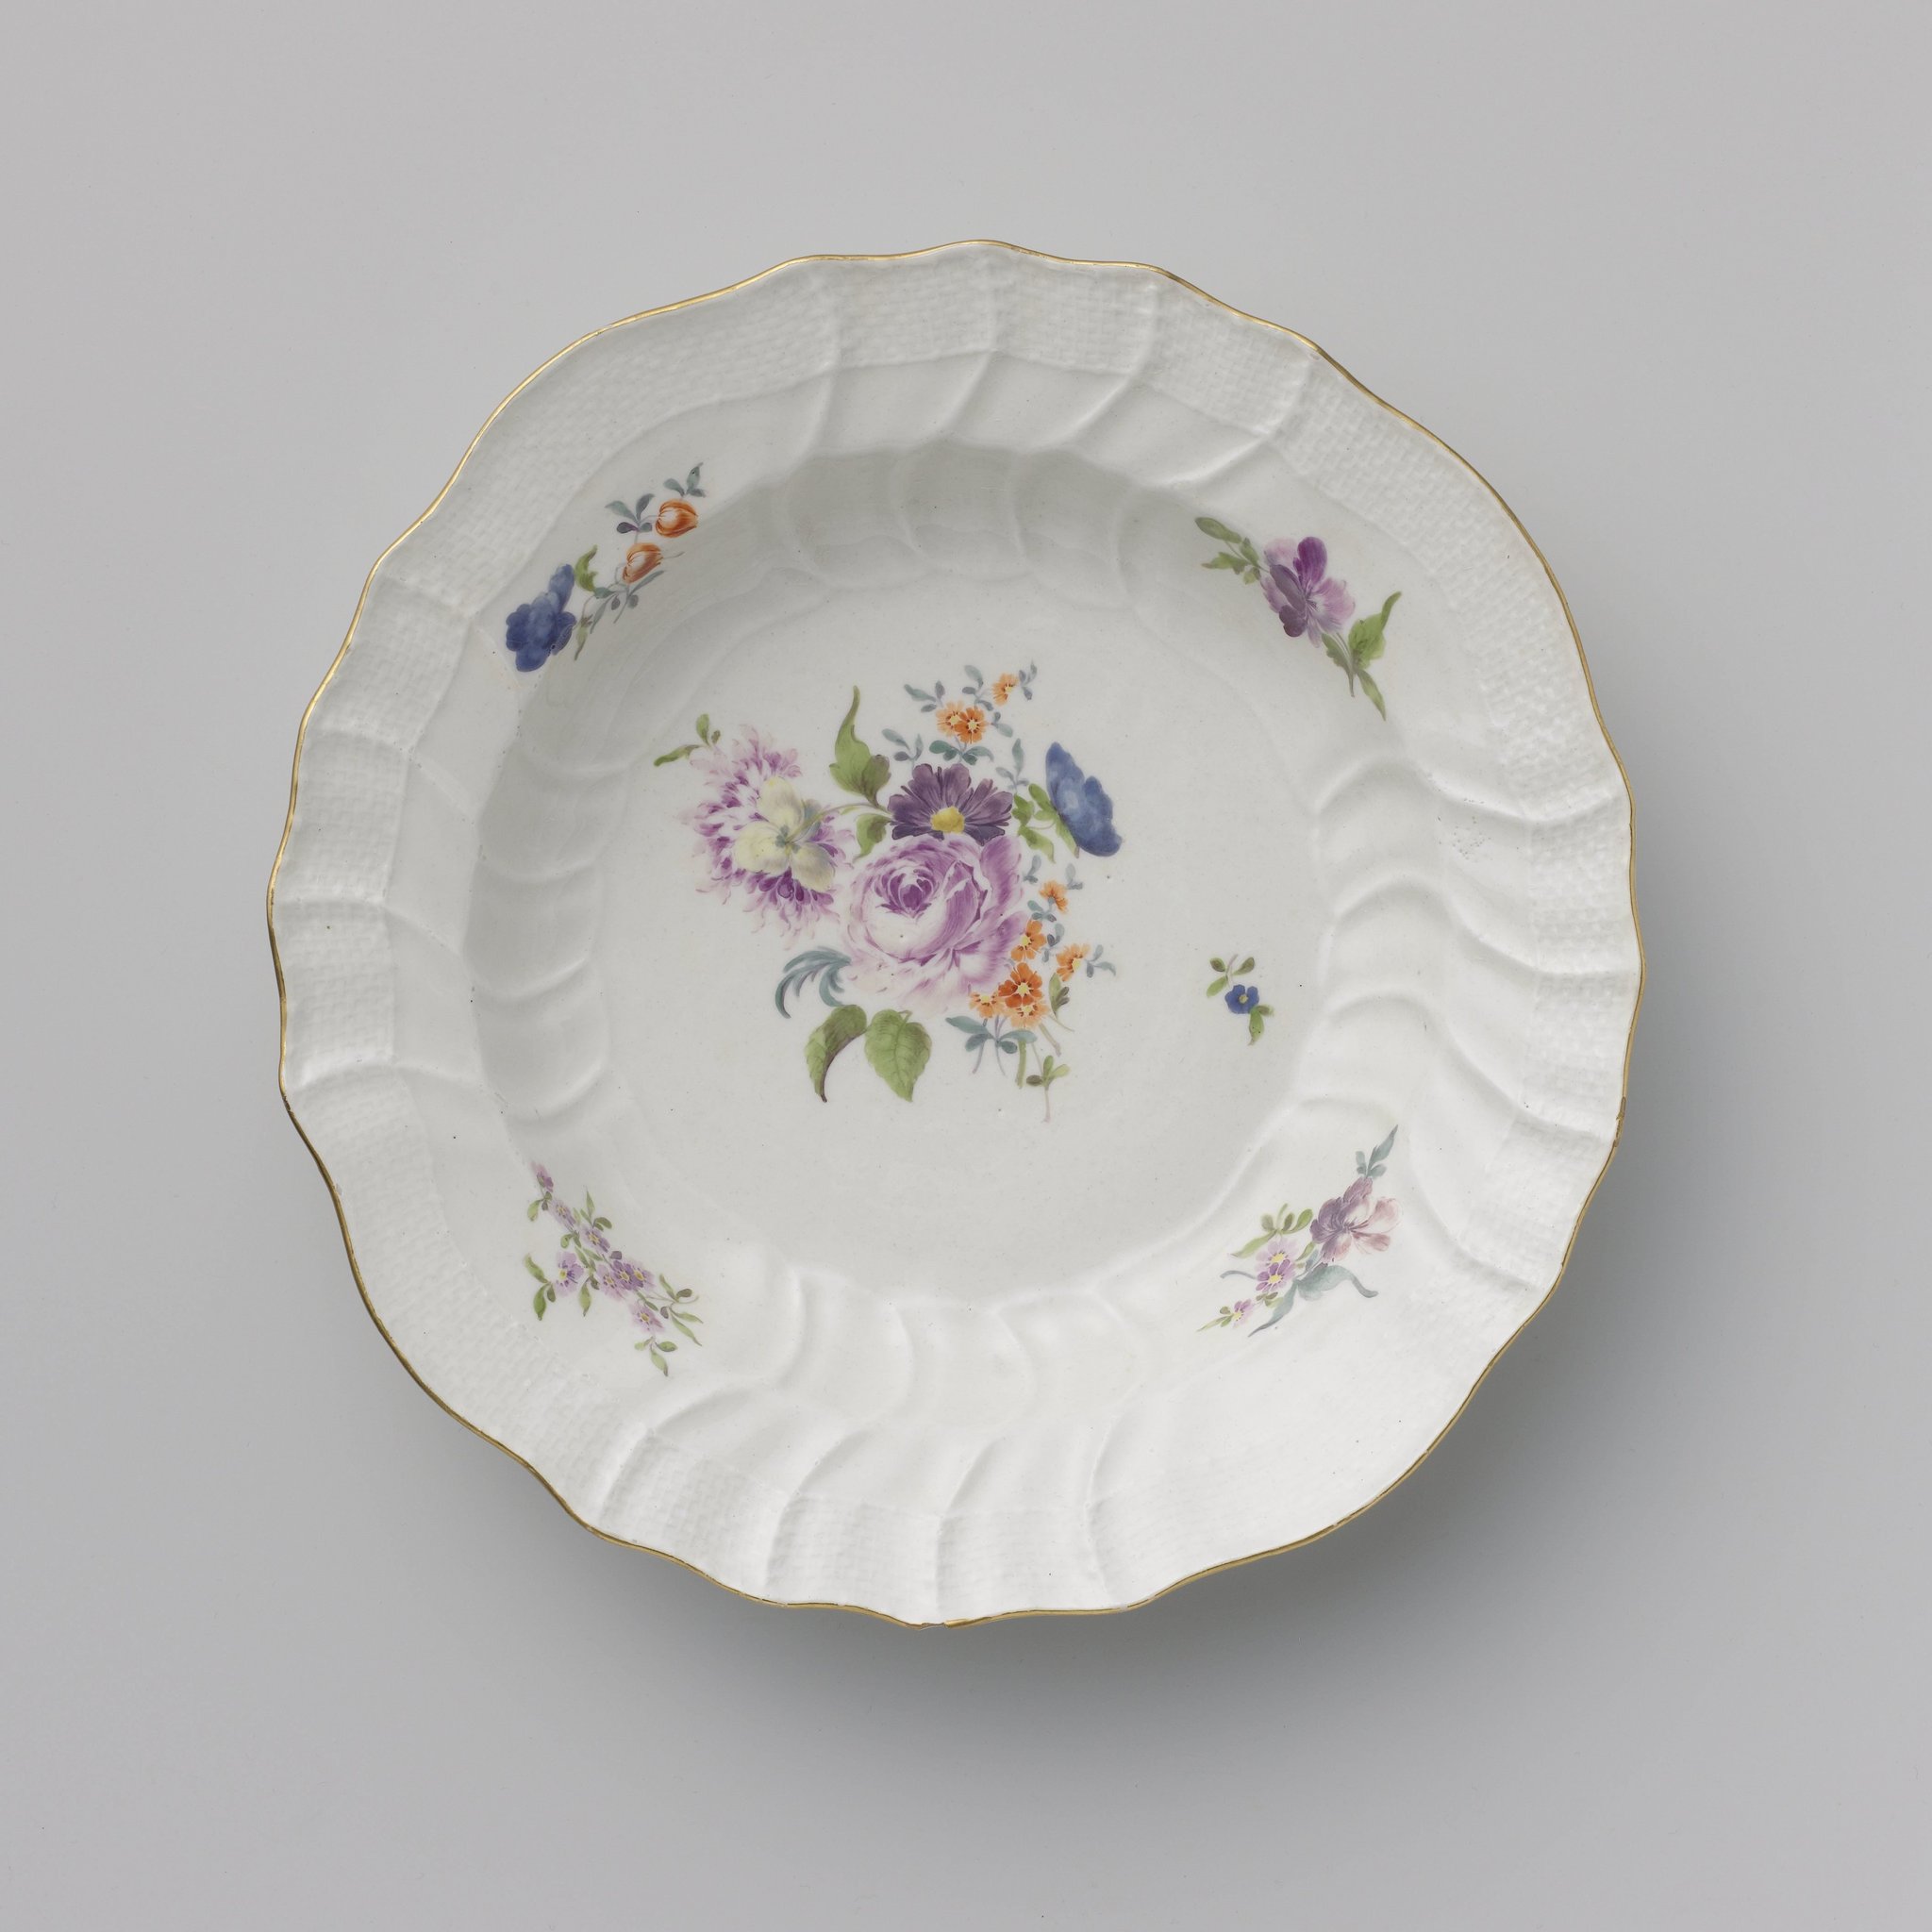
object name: soup plate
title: Bord, veelkleurig beschilderd met Deutsche Blumen, insekten en vruchten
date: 1750-1760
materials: porcelain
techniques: painted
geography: meissen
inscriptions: factory mark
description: Rond soepbord van beschilderd porselein. Het bord is beschilderd met Deutsche Blumen, insekten en vruchten. De rand is in reliëf versierd met het Neuozier-patroon. Het bord is gemerkt en hoort bij een servies (BK-17474-1 t/m BK-17474-253).